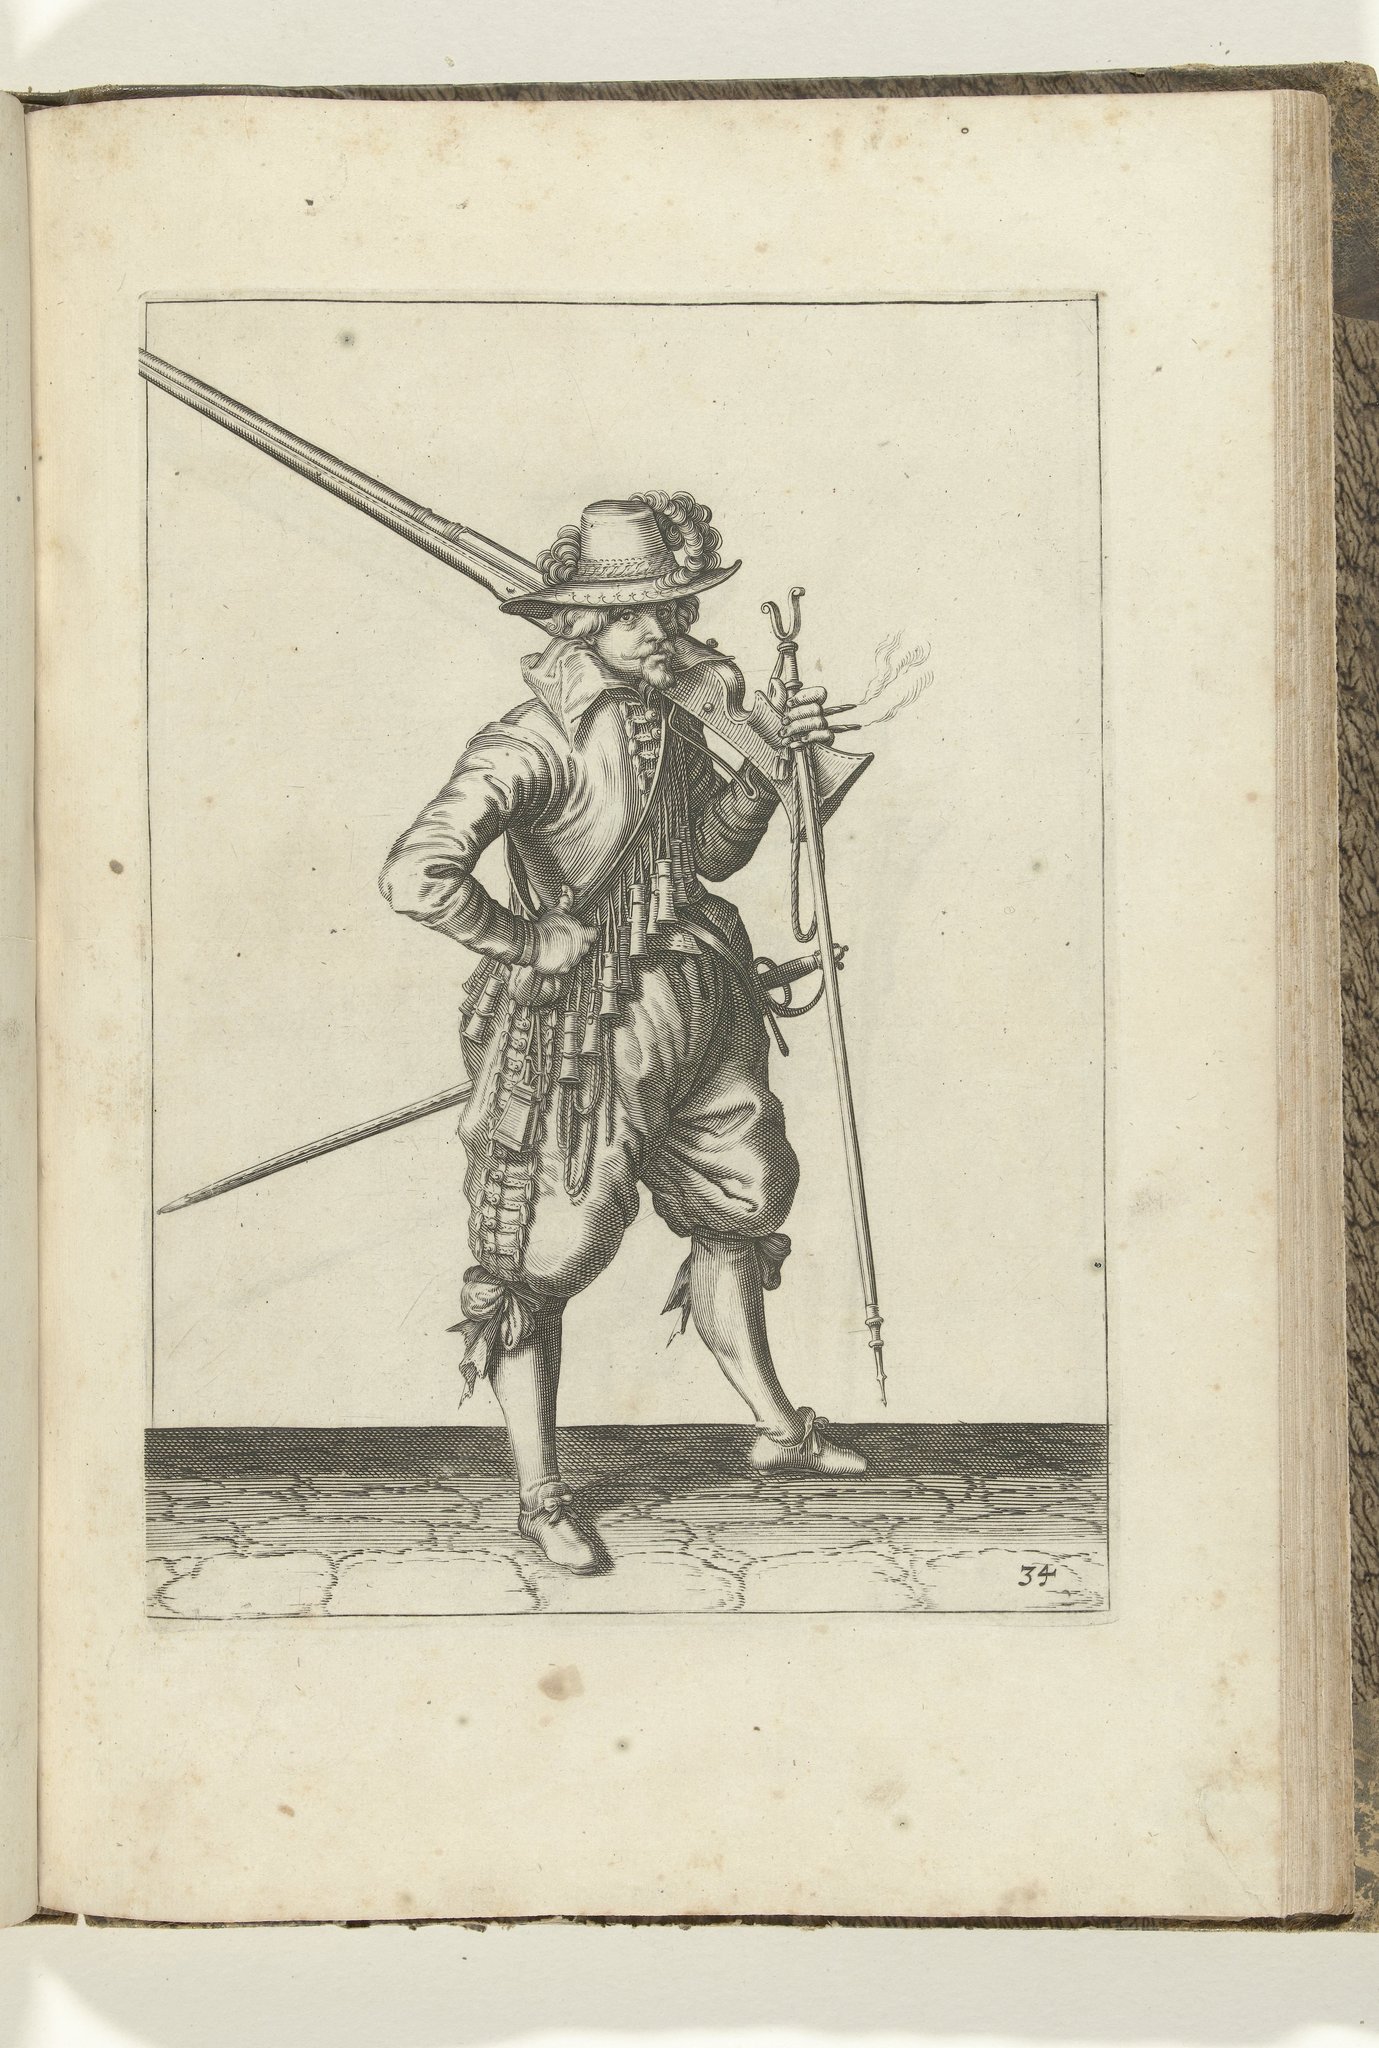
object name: print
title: Soldaat die zijn musket op zijn schouder draagt (nr. 34), ca. 1600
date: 1597-1608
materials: paper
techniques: engraving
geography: amsterdam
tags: maurice (prince of orange), handling of weapons ~ military training, weapons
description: Een soldaat, ten voeten uit, naar rechts, met een musket (een bepaald type vuurwapen) steunend op zijn linkerschouder (nr. 34), ca. 1600. In zijn linkerhand behalve de kolf van het musket ook een brandende lont en een furket (musketvork). Het gaat dus om (vrijwel) dezelfde positie als degene die op de tweede prent van de serie getoond wordt. Rechtsonder eerst foutief genummerd 2, verbeterd in 34. Plaat 34 in de instructies voor het hanteren van het musket: Brief enseignement, sur les pourtraitz figurez, touchant le droit maniement du Mousquet. Onderdeel van de illustraties in een Franse editie van J. de Gheyns Wapenhandelinghe: J. de Gheyn, Maniement d'armes, d'arquebuses, mousquetz et piques : en conformité de l'ordre de Mour le Prince Maurice, Prince d'Orange, Amsterdam 1608. Krijgswezen rond 1600.